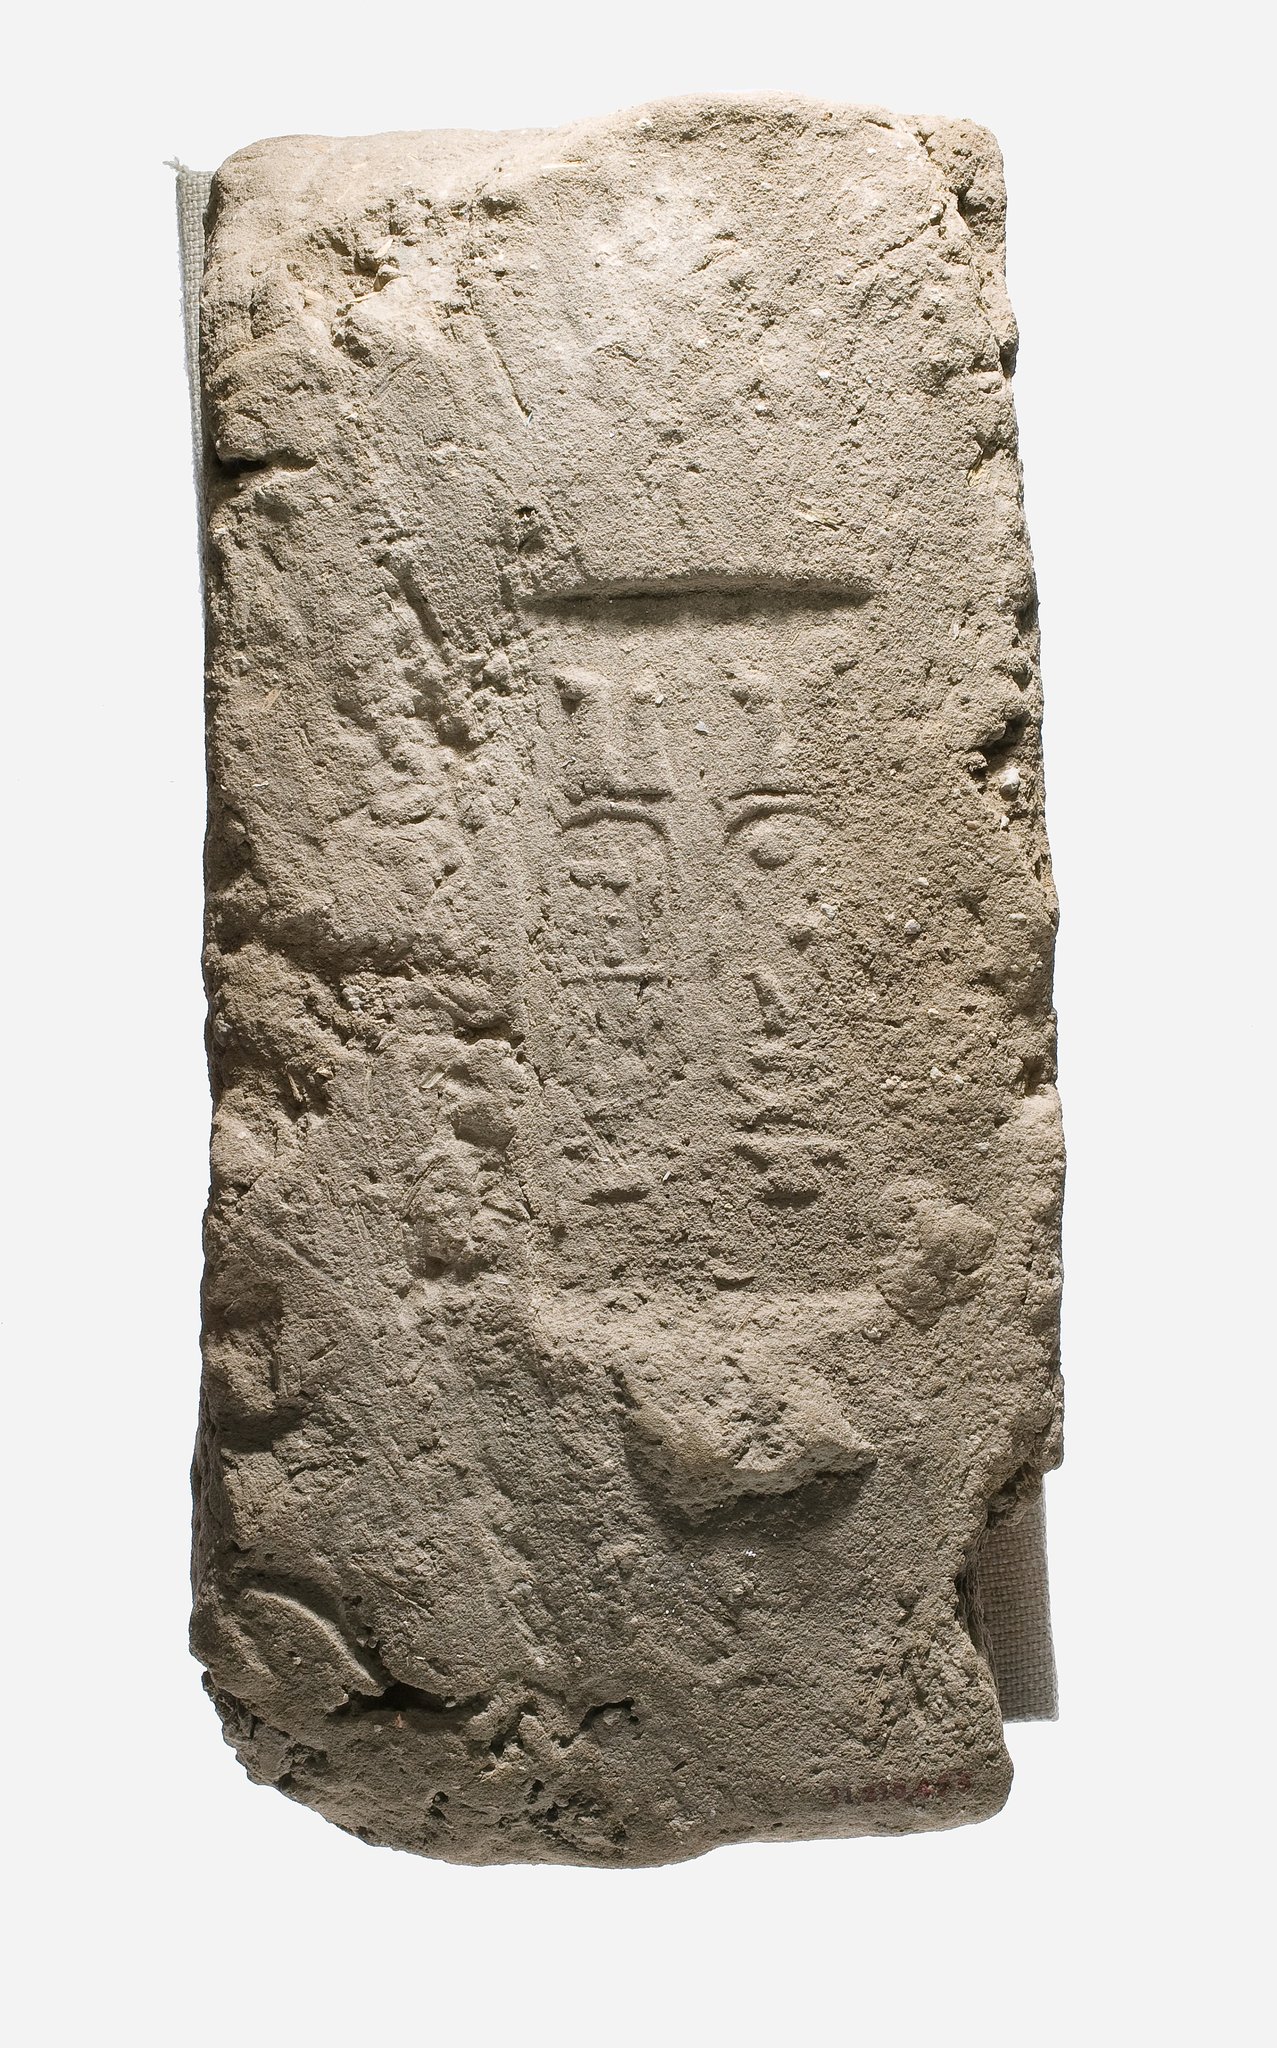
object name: brick, amenhotep iii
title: Brick stamped with the Names of Amenhotep III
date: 1390-1352 BCE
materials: mud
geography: egypt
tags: cartouches